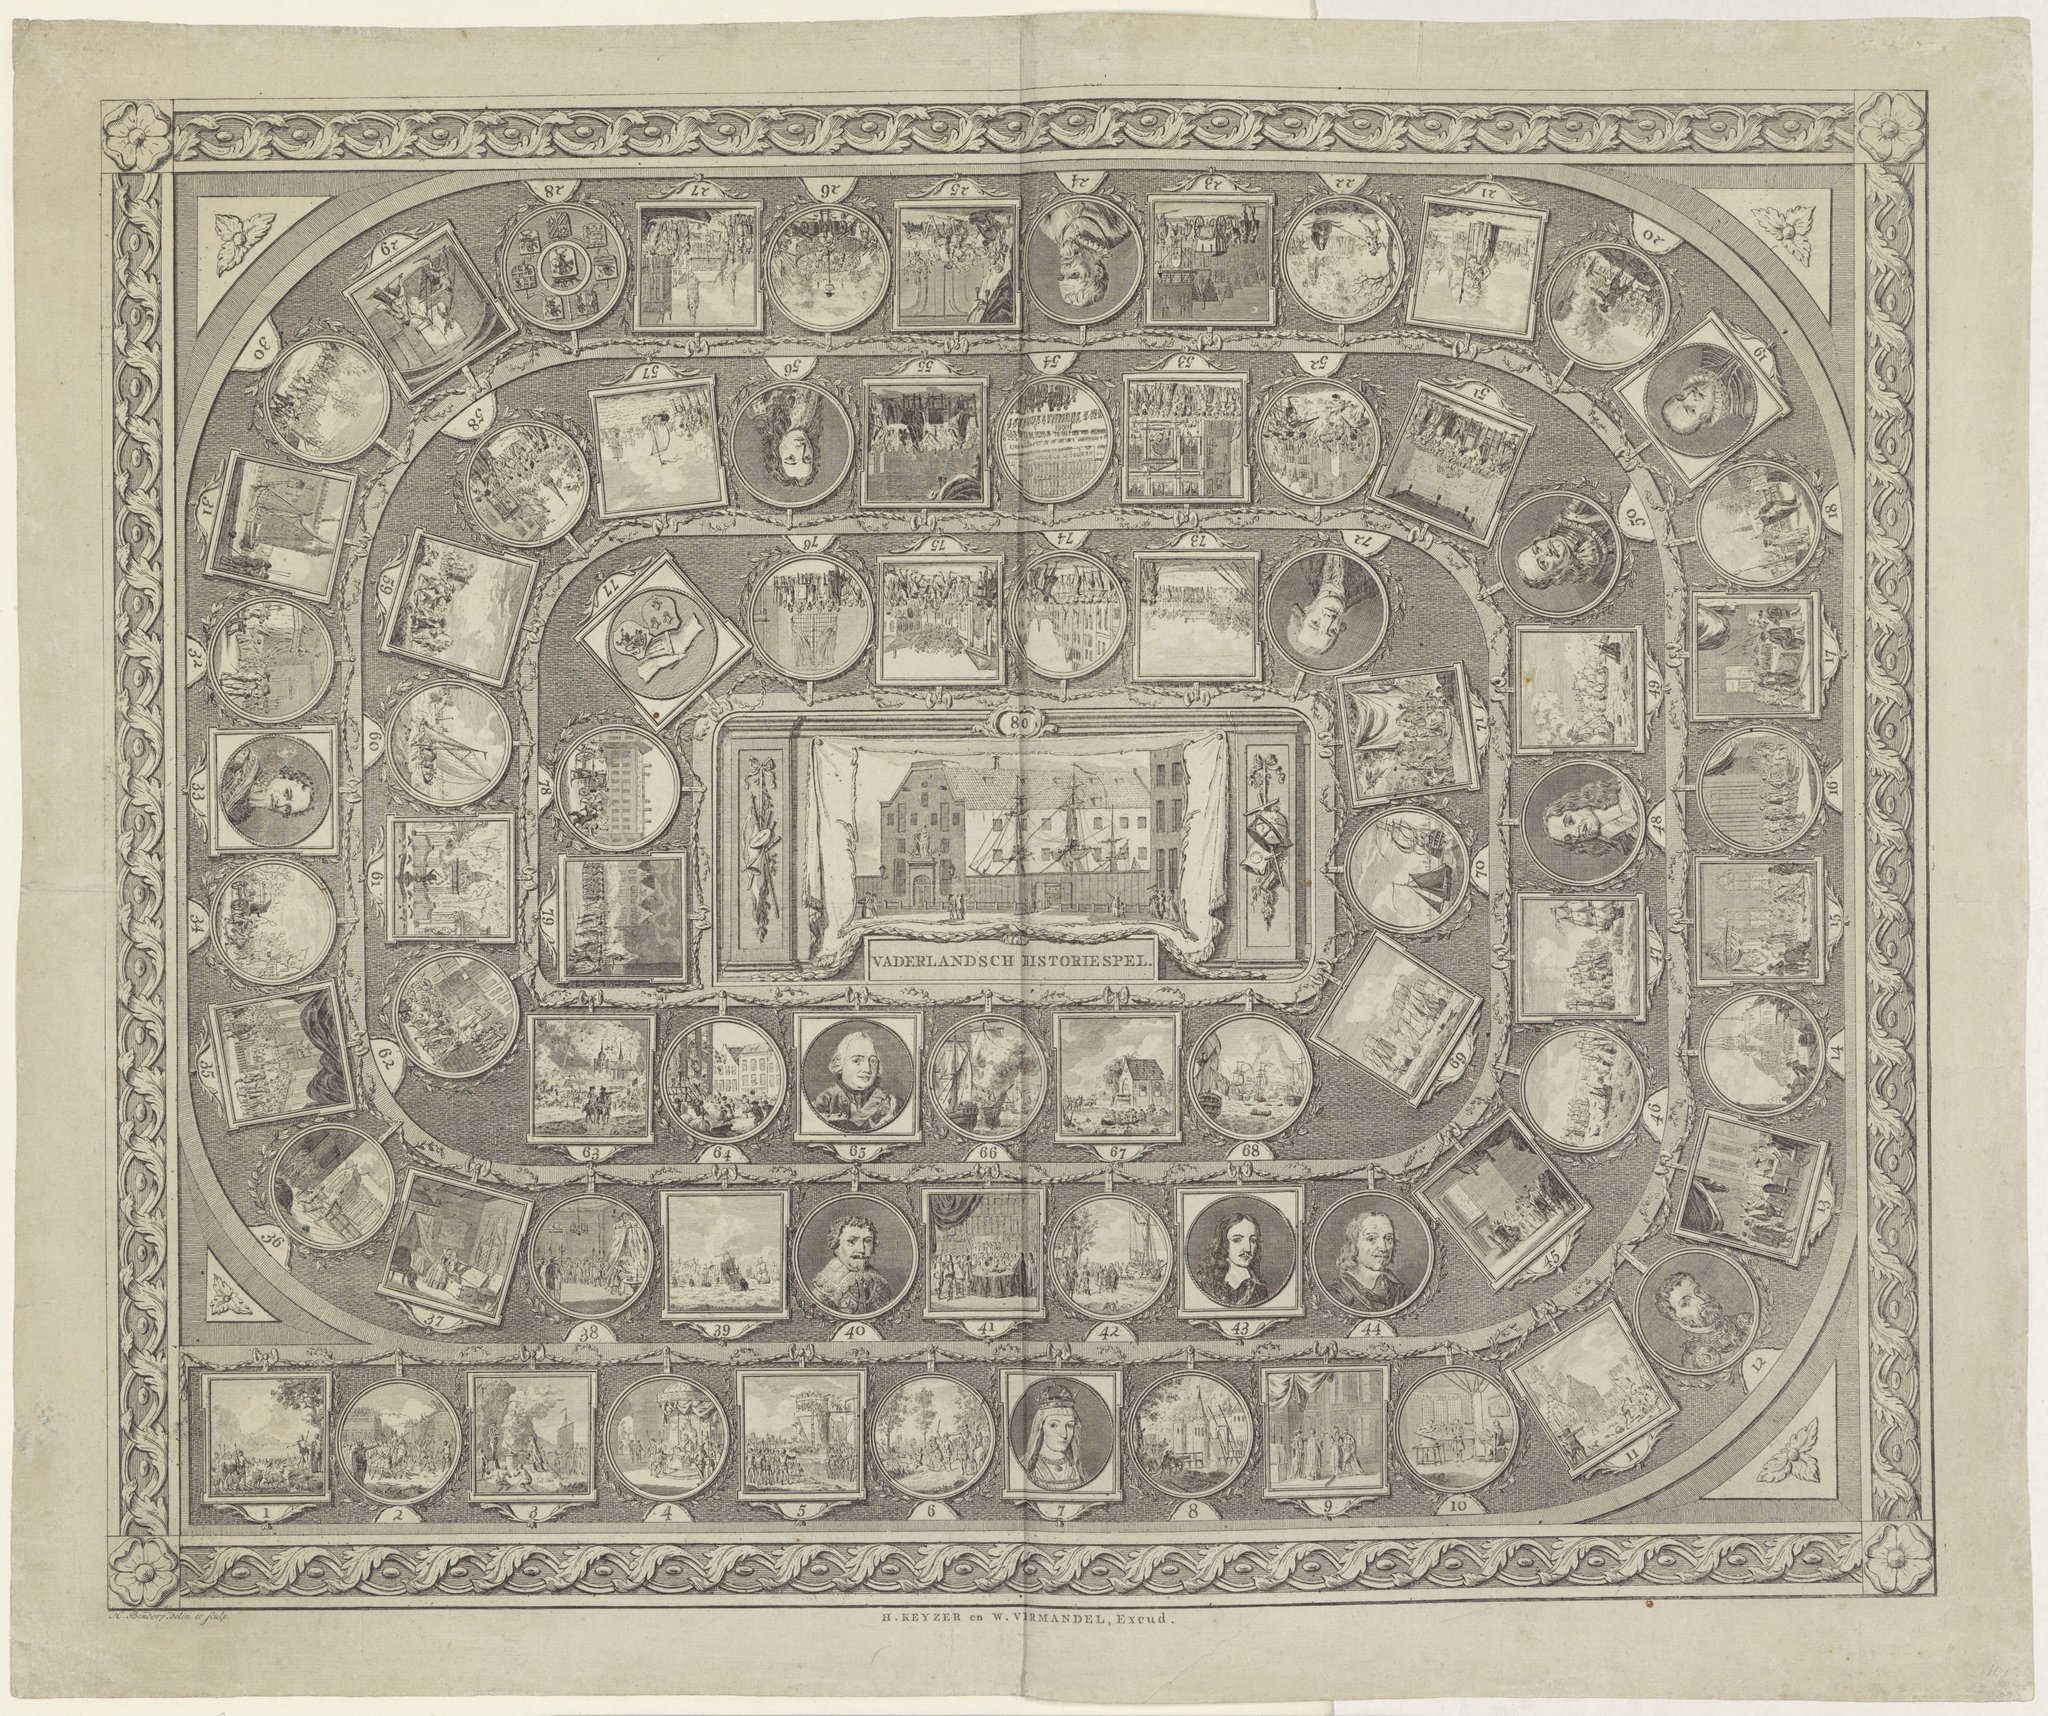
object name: popular print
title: Vaderlandsch historiespel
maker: johannes christiaan bendorp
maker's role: print maker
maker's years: 1766-1849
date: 1787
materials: paper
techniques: etching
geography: netherlands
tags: board-games of chance, board-games, netherlands, low countries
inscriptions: collector's mark: Lugt 2760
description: Spiraalvormig bordspel met genummerde vakjes van 1 tot en met 80, geeft in 80 portretten en taferelen een beeldverhaal van de Nederlandse geschiedenis, beginnend met de komst van de Batavieren tot aan de beëdiging van de schutterij te Utrecht in 1786. Centraal staat, bij 80, een afbeelding van de in 1785 te Amsterdam gebouwde kweekschool voor de zeevaart. Omgeven door een sierlijst.